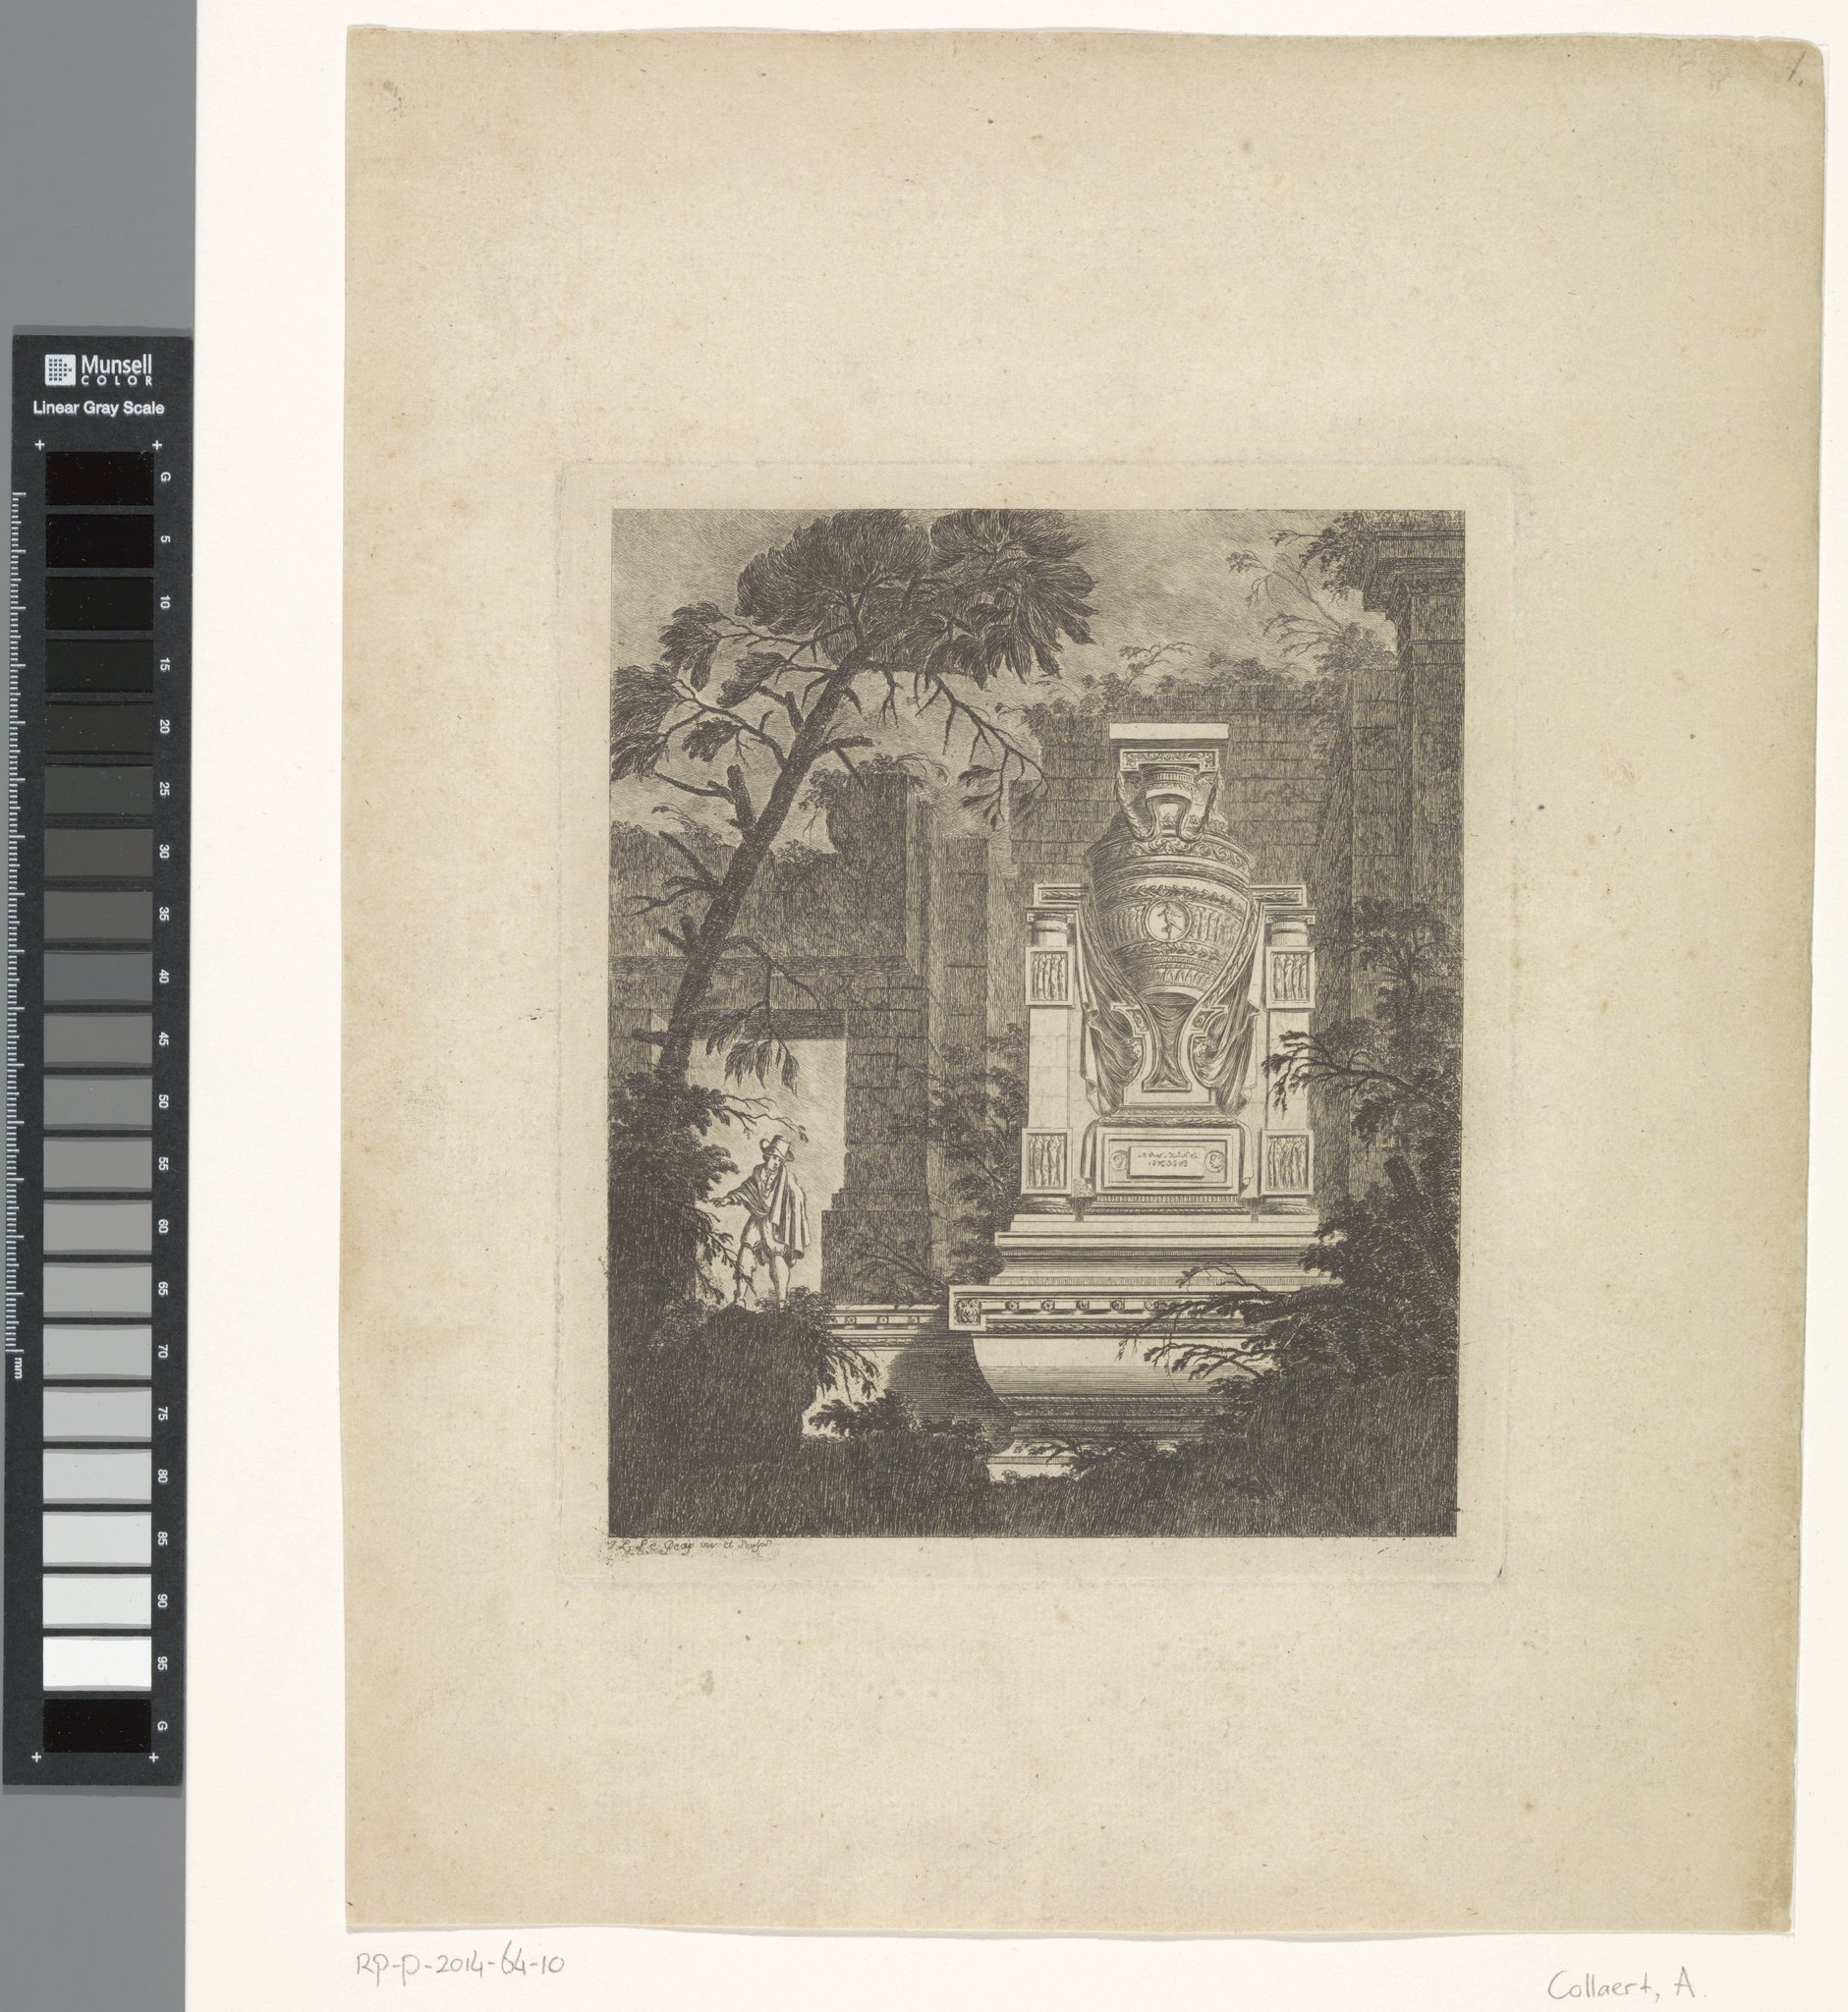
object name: ornament print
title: Landschap met groteske vazen, ruïnes en andere antieke overblijfselen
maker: jean laurent legeay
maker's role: print maker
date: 1767-1770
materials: paper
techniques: etching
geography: france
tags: vase ~ ornament, landscape with ruins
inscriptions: collector's mark: Lugt 2228, collector's mark: Lugt 2760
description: Landschap met groteske vazen, ruïnes en andere antieke overblijfselen. Links een staande man. Onderdeel van groep prenten afkomstig uit één van de vier series van vazen, ruïnes, tombes en fonteinen met in totaal ca. 25 bladen.